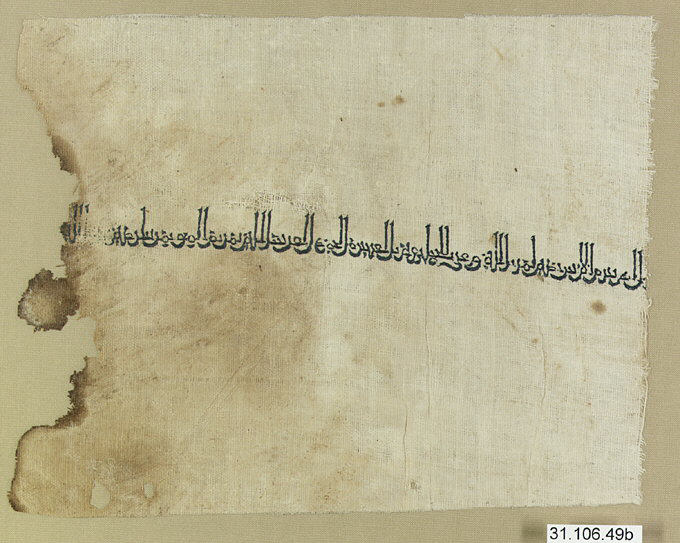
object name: textile fragment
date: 991-1031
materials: linen, silk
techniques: embroidery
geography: egypt